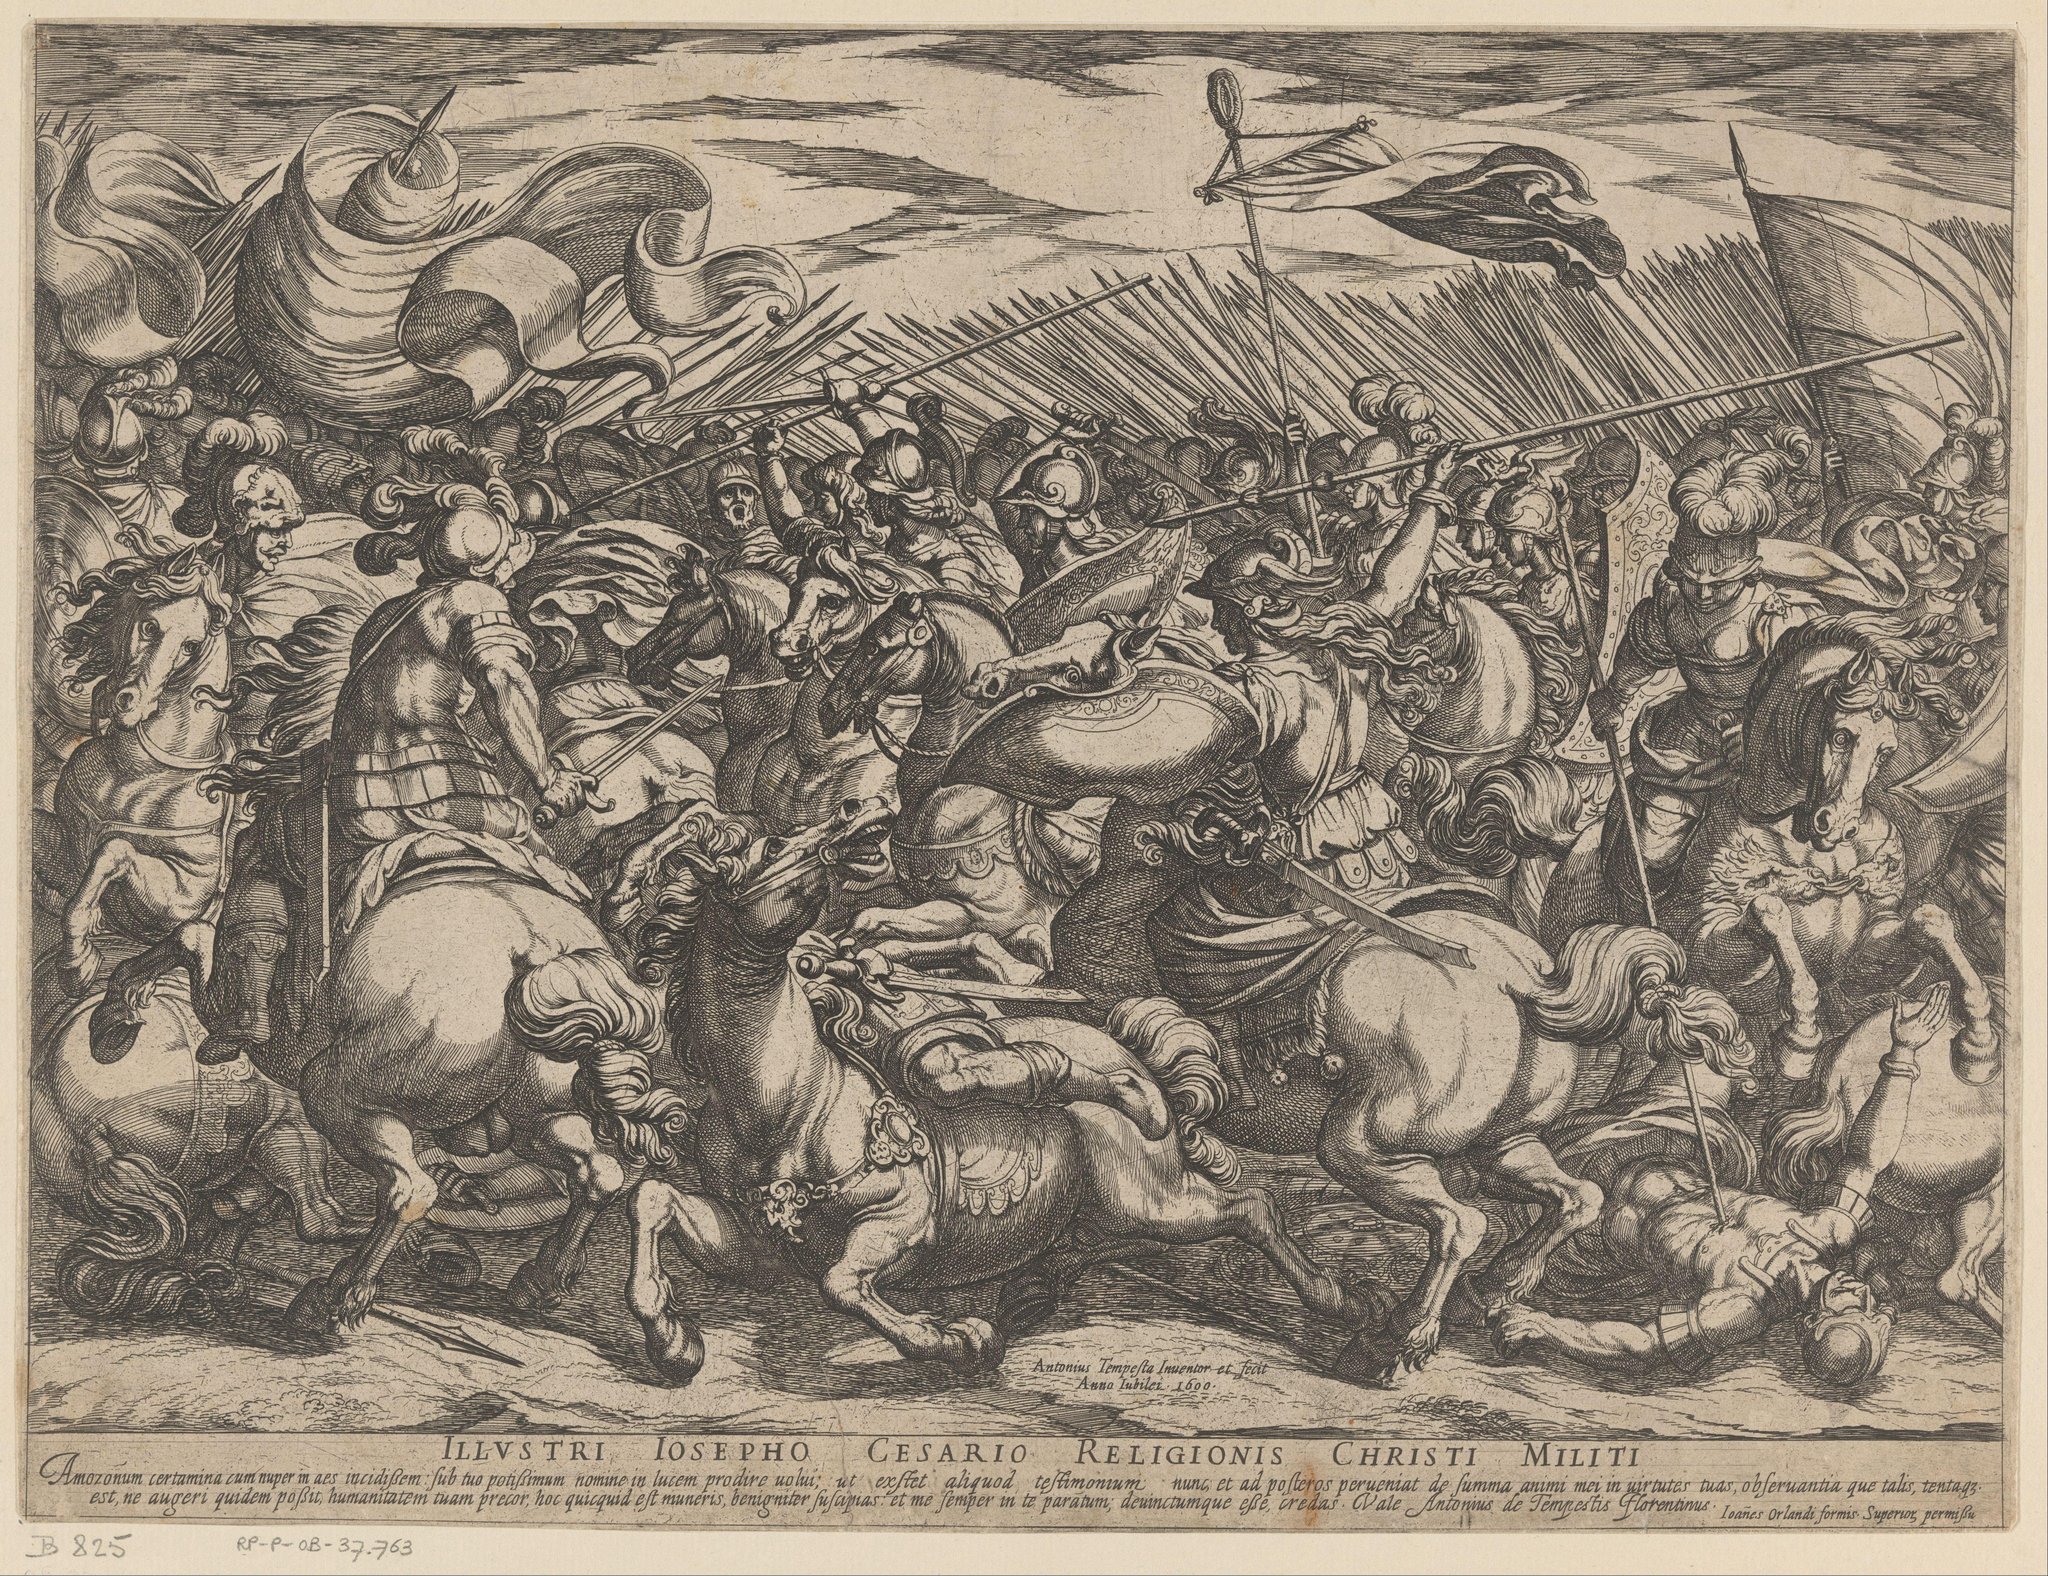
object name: print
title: Strijd tussen de Grieken en de Amazones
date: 1600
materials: paper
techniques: etching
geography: italy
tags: (story of) the amazons, battle, the soldier; the soldier's life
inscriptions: collector's mark: Lugt 240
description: Griekse soldaten strijden tegen de vrouwelijke Amazones te paard en met speren. Opdracht in het Latijn in ondermarge.